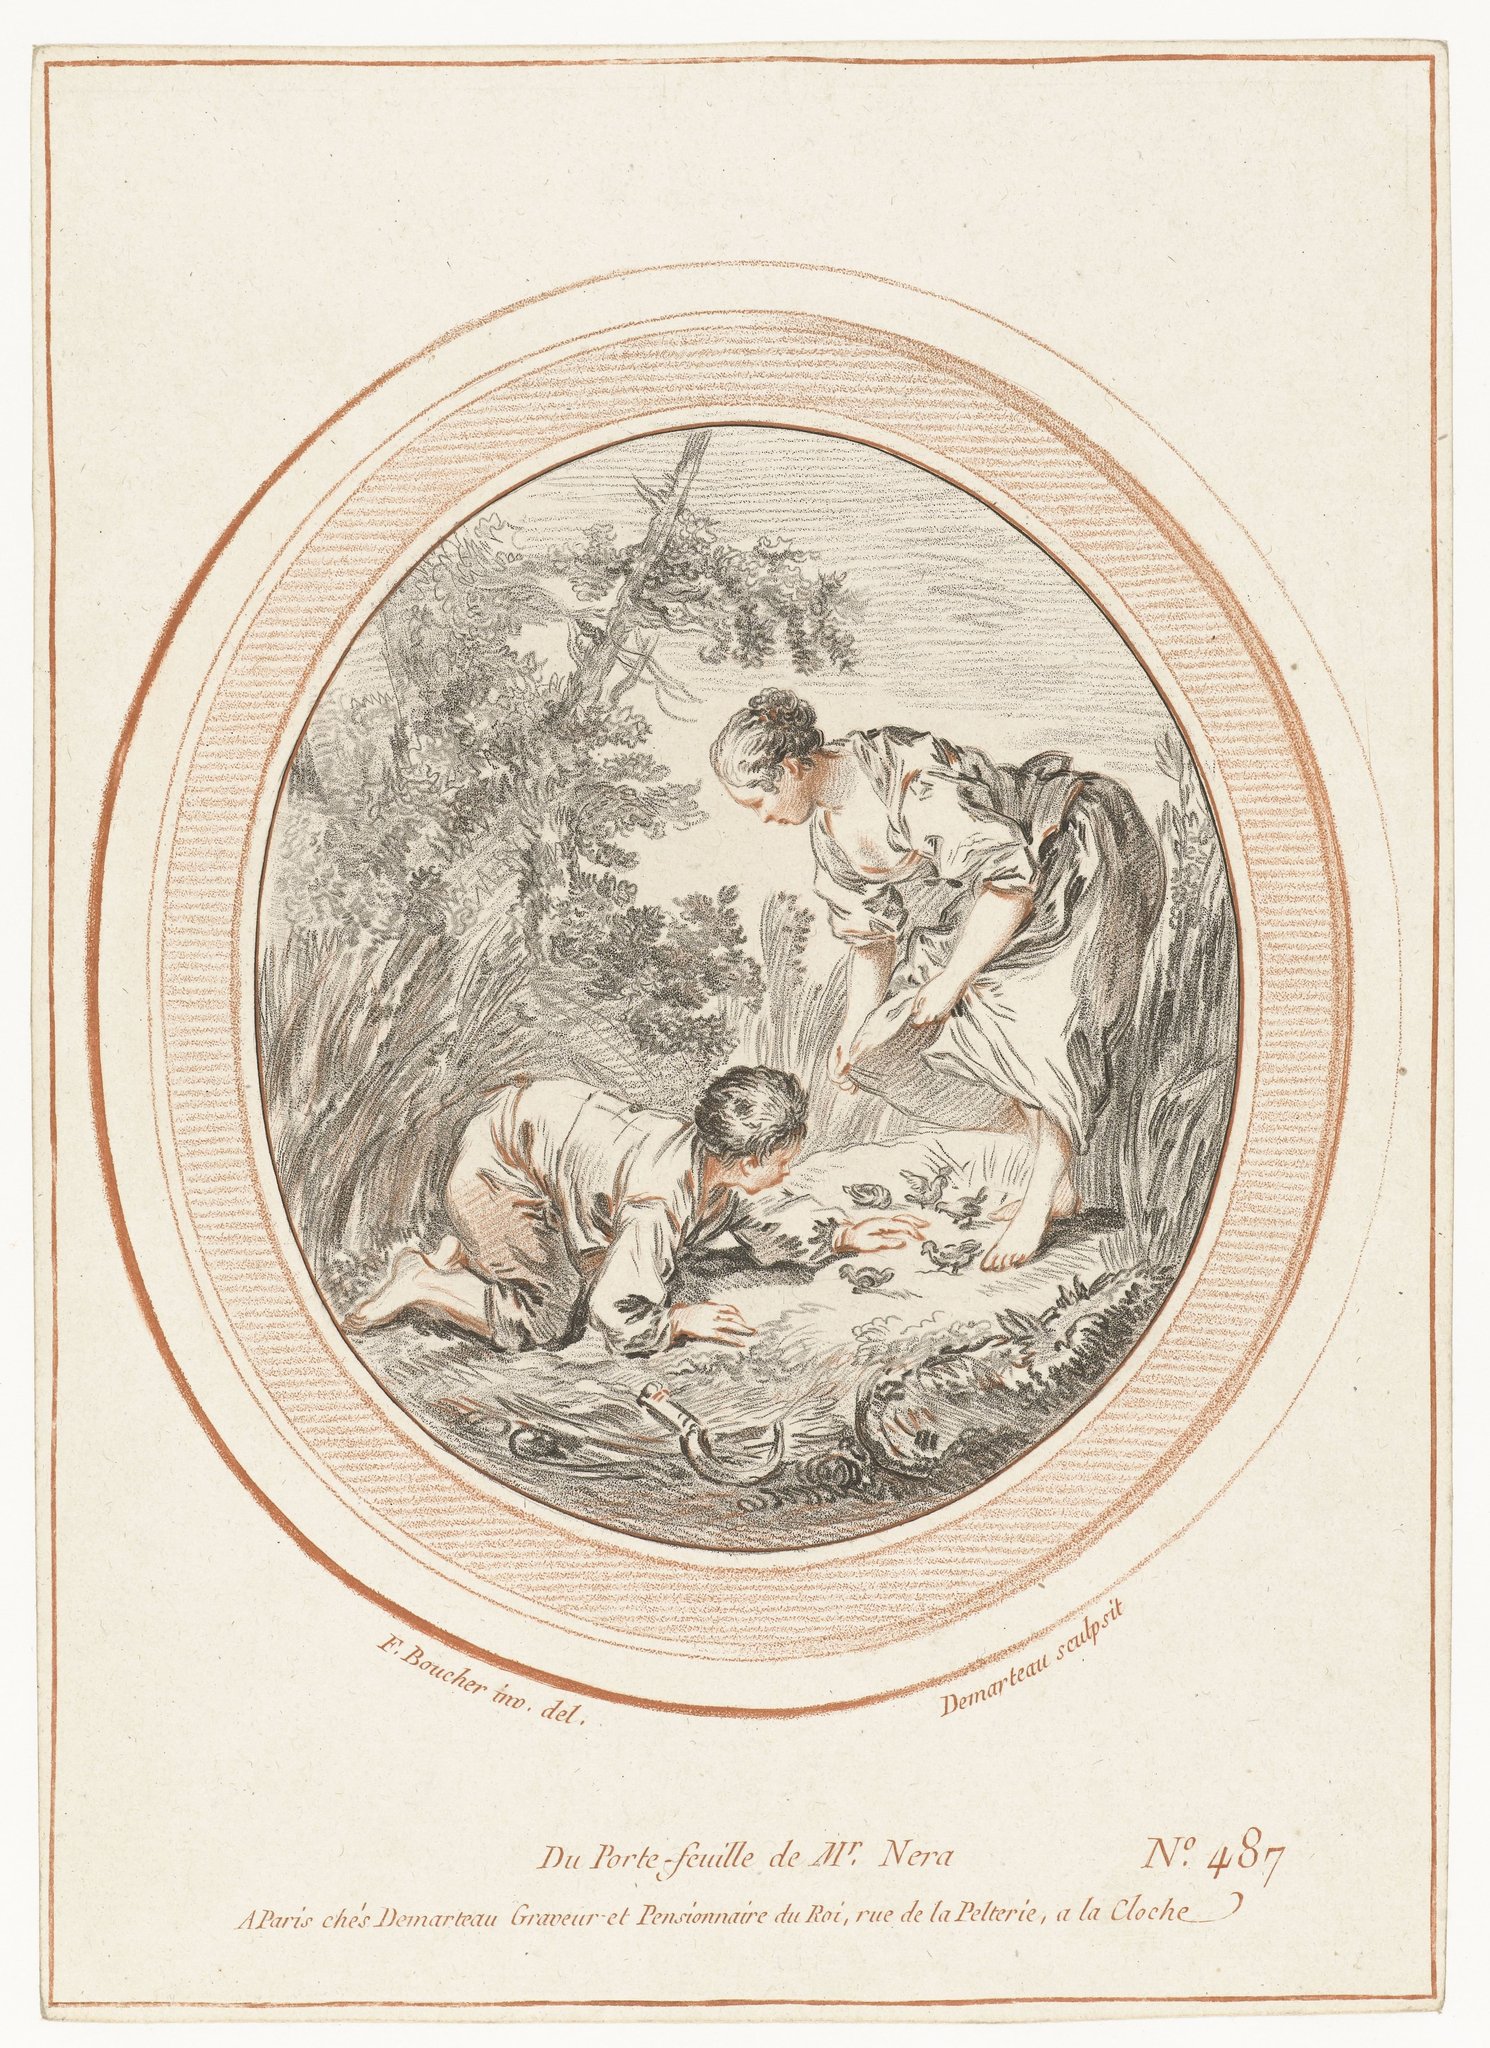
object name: print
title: Boerenjongen en meisje met kuikens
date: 1756-1776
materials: paper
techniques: printing, printmaking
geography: paris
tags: birds, youth, adolescent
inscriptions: collector's mark: Lugt 2760, collector's mark: Lugt 2228, inscription: ‘Du Porte-Feuille de Mr. Nera’, number: ‘No. 487’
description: Een jongen, geknield op de grond, en een meisje kijken naar een groepje van vijf kuikens. Een ovale omlijsting.